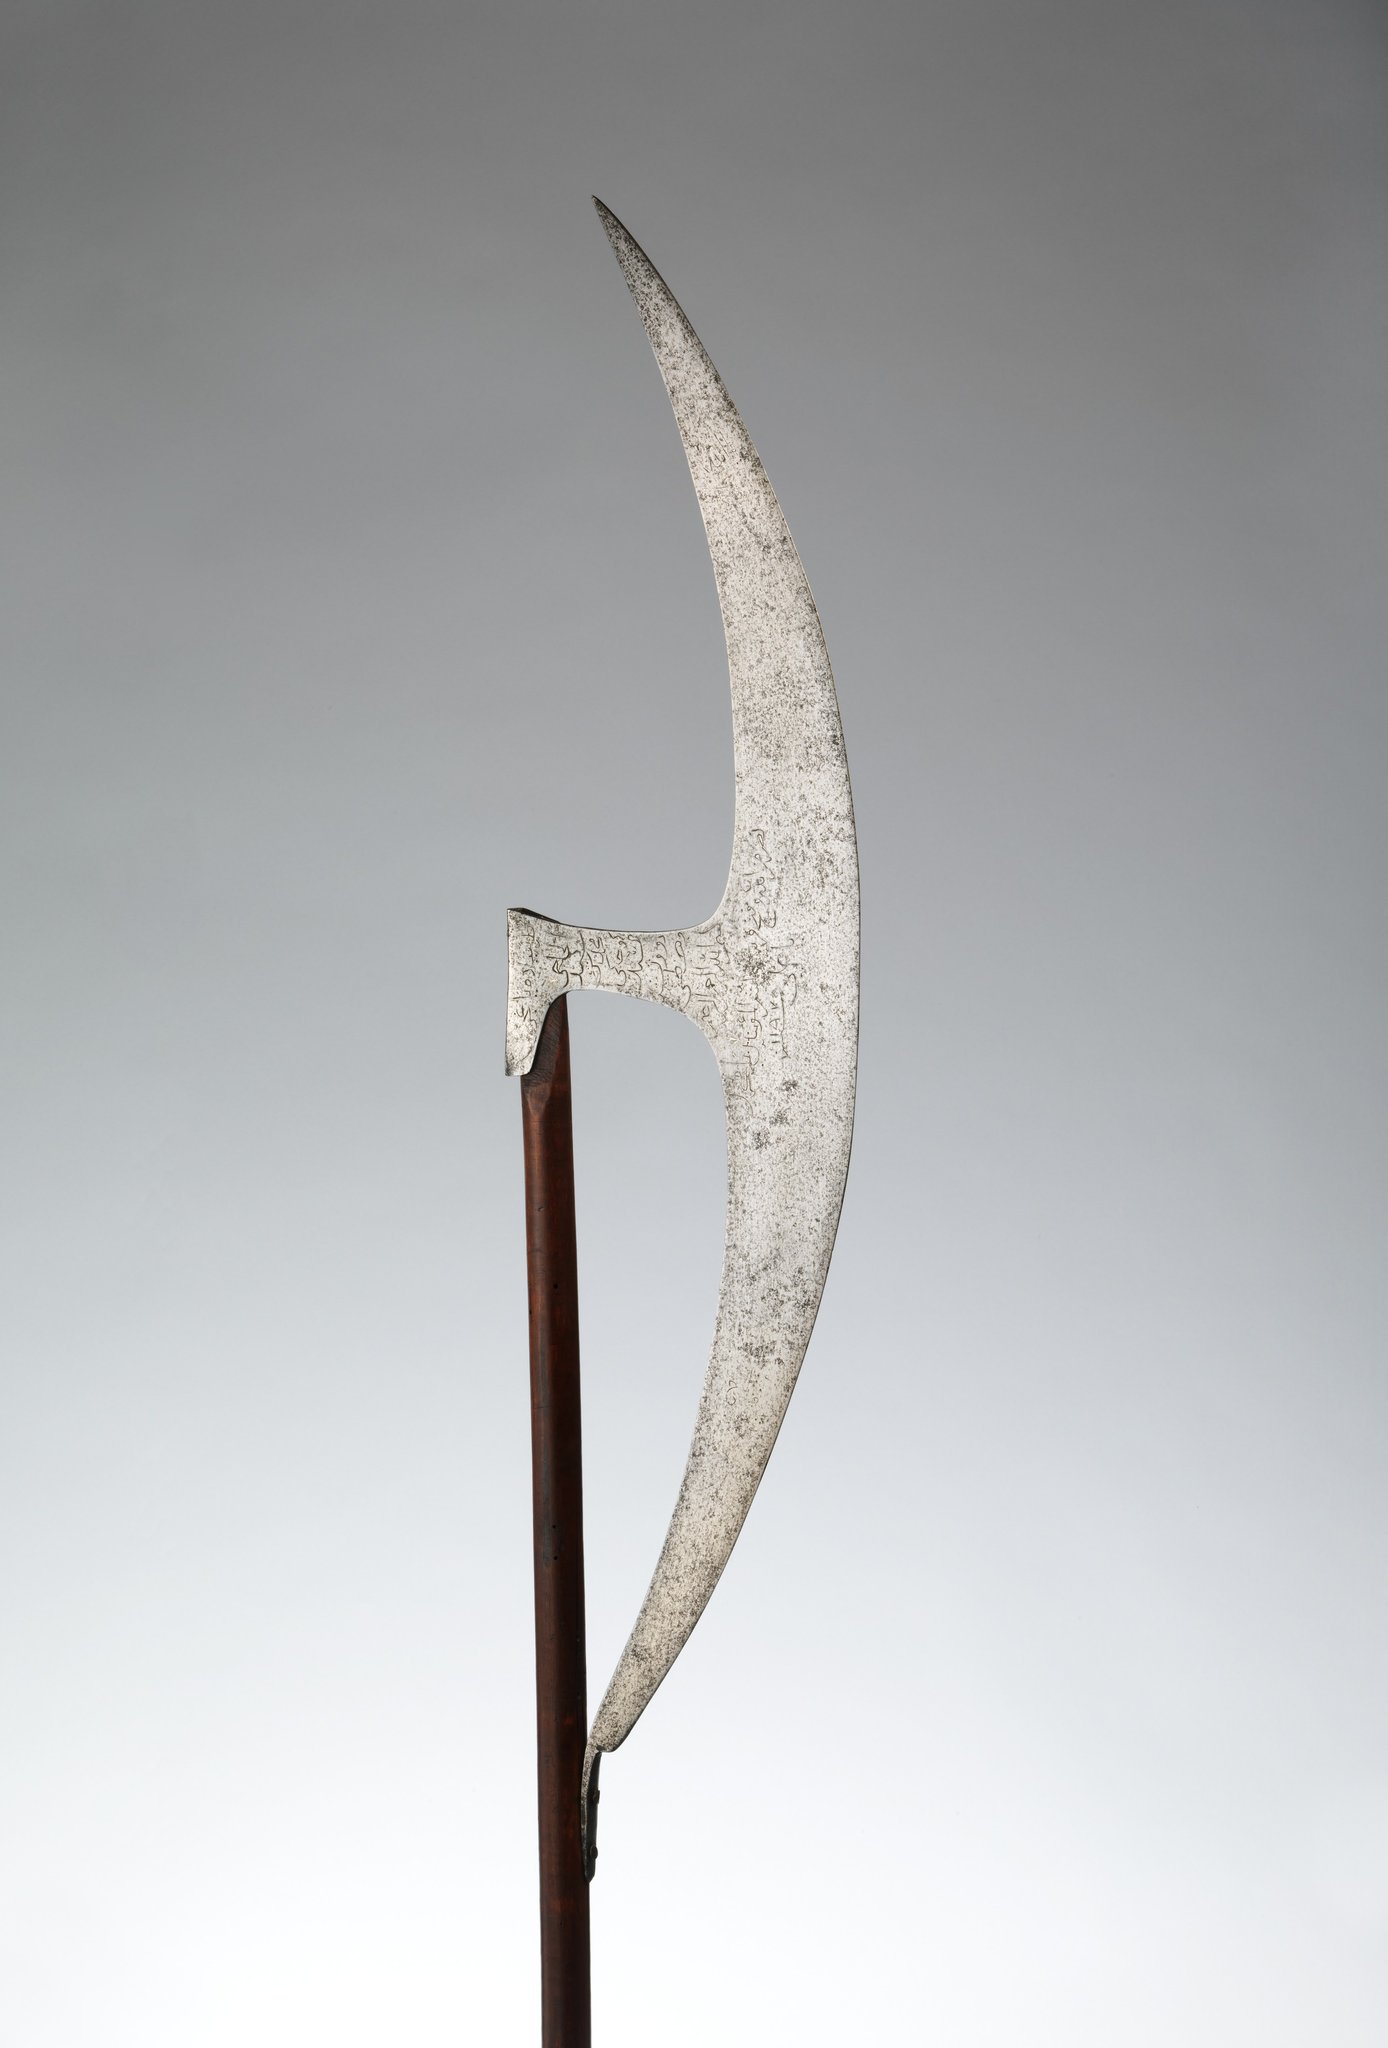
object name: axe berdiche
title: Axe (Berdiche)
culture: turkish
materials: silver, steel, wood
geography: ottoman empire